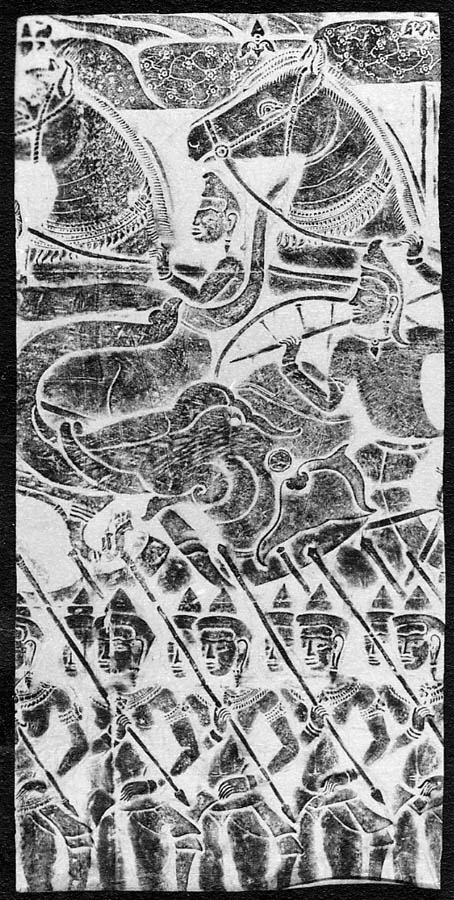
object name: rubbing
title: Rubbing of the Churning of the Sea of Milk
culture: cambodian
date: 1901-2000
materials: ink, paper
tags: spears,men